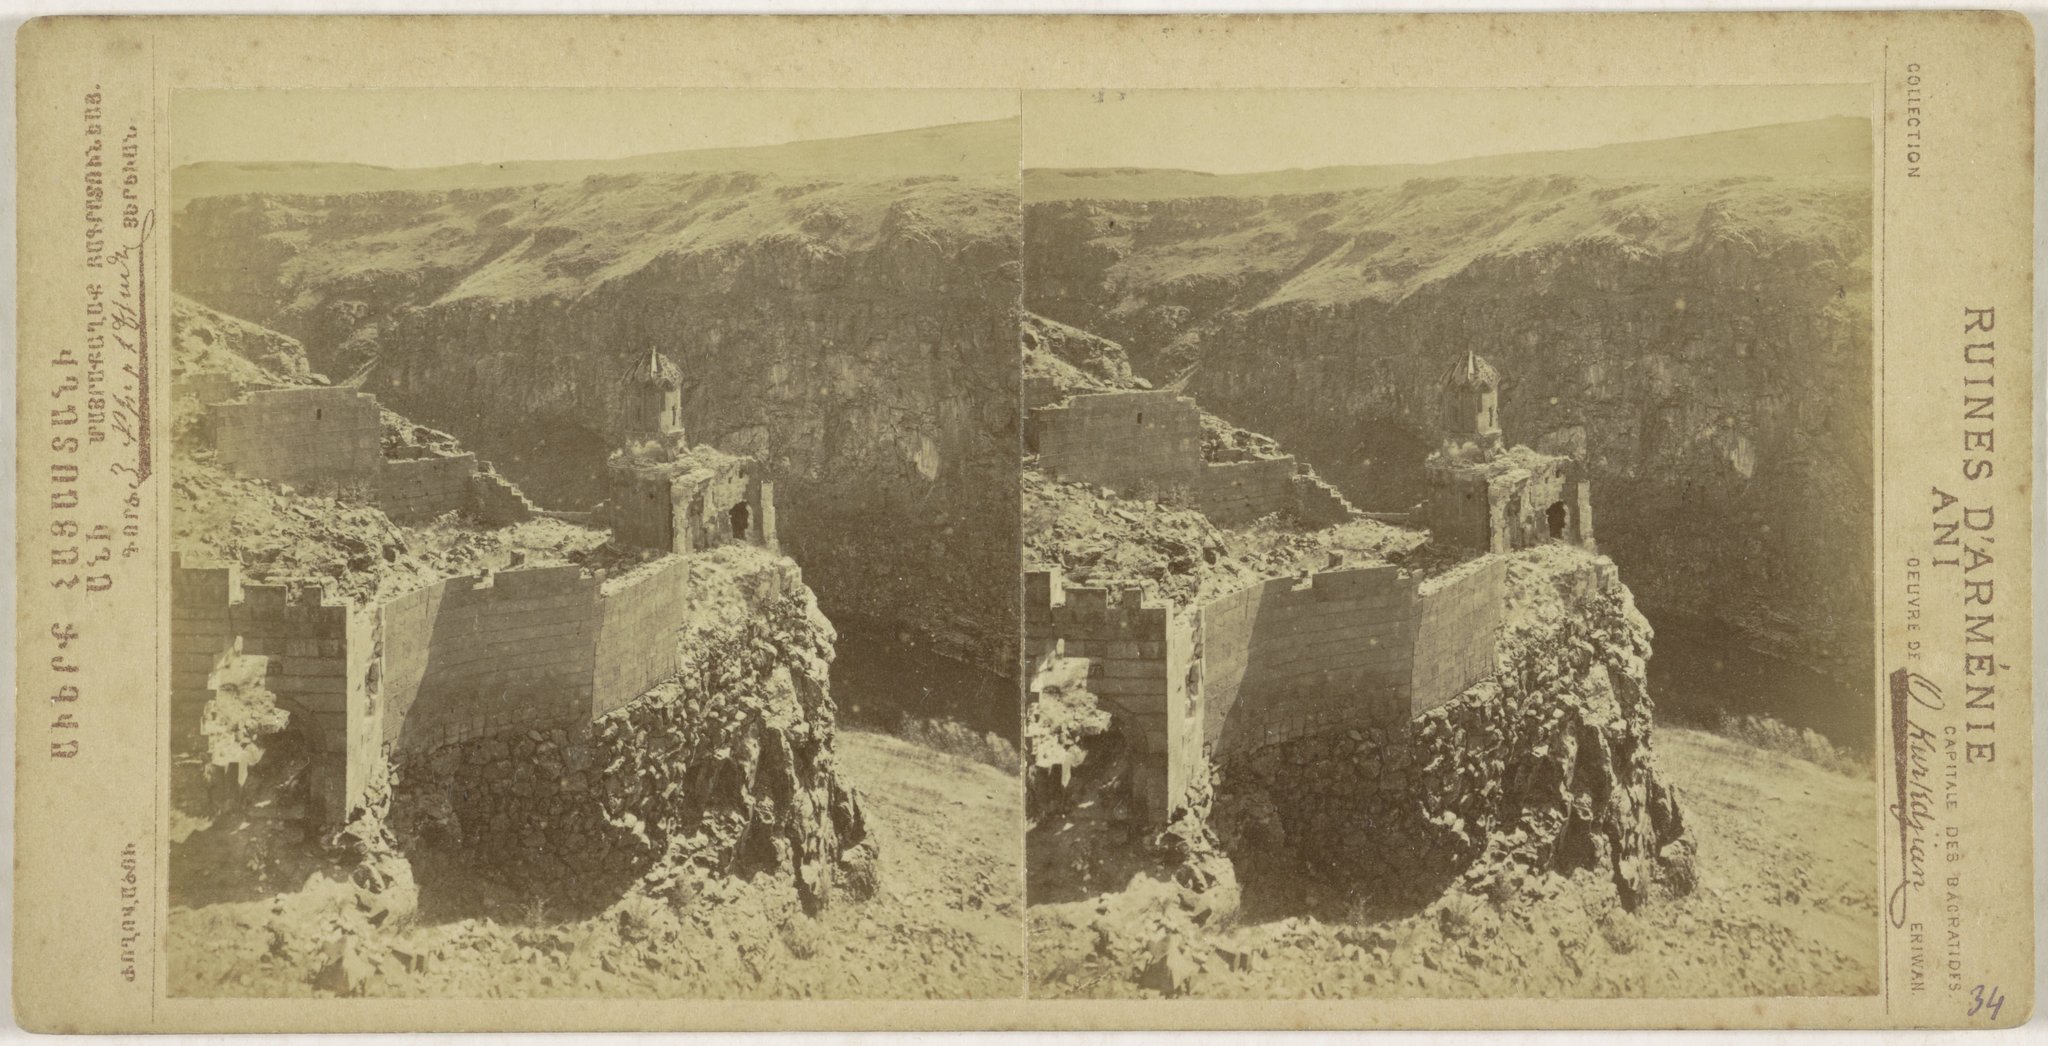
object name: stereograph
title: Ruines d'Arménie. Ani Capitale des Bagratides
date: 1875-1880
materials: cardboard, paper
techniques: albumen print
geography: ocaklı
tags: ruin of church, monastery, etc.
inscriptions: inscription: ‘Collection Oeuvre de O. Kurkdjian Eriwan’, number: ‘34’, inscription: ‘Tous droits résérvés.’